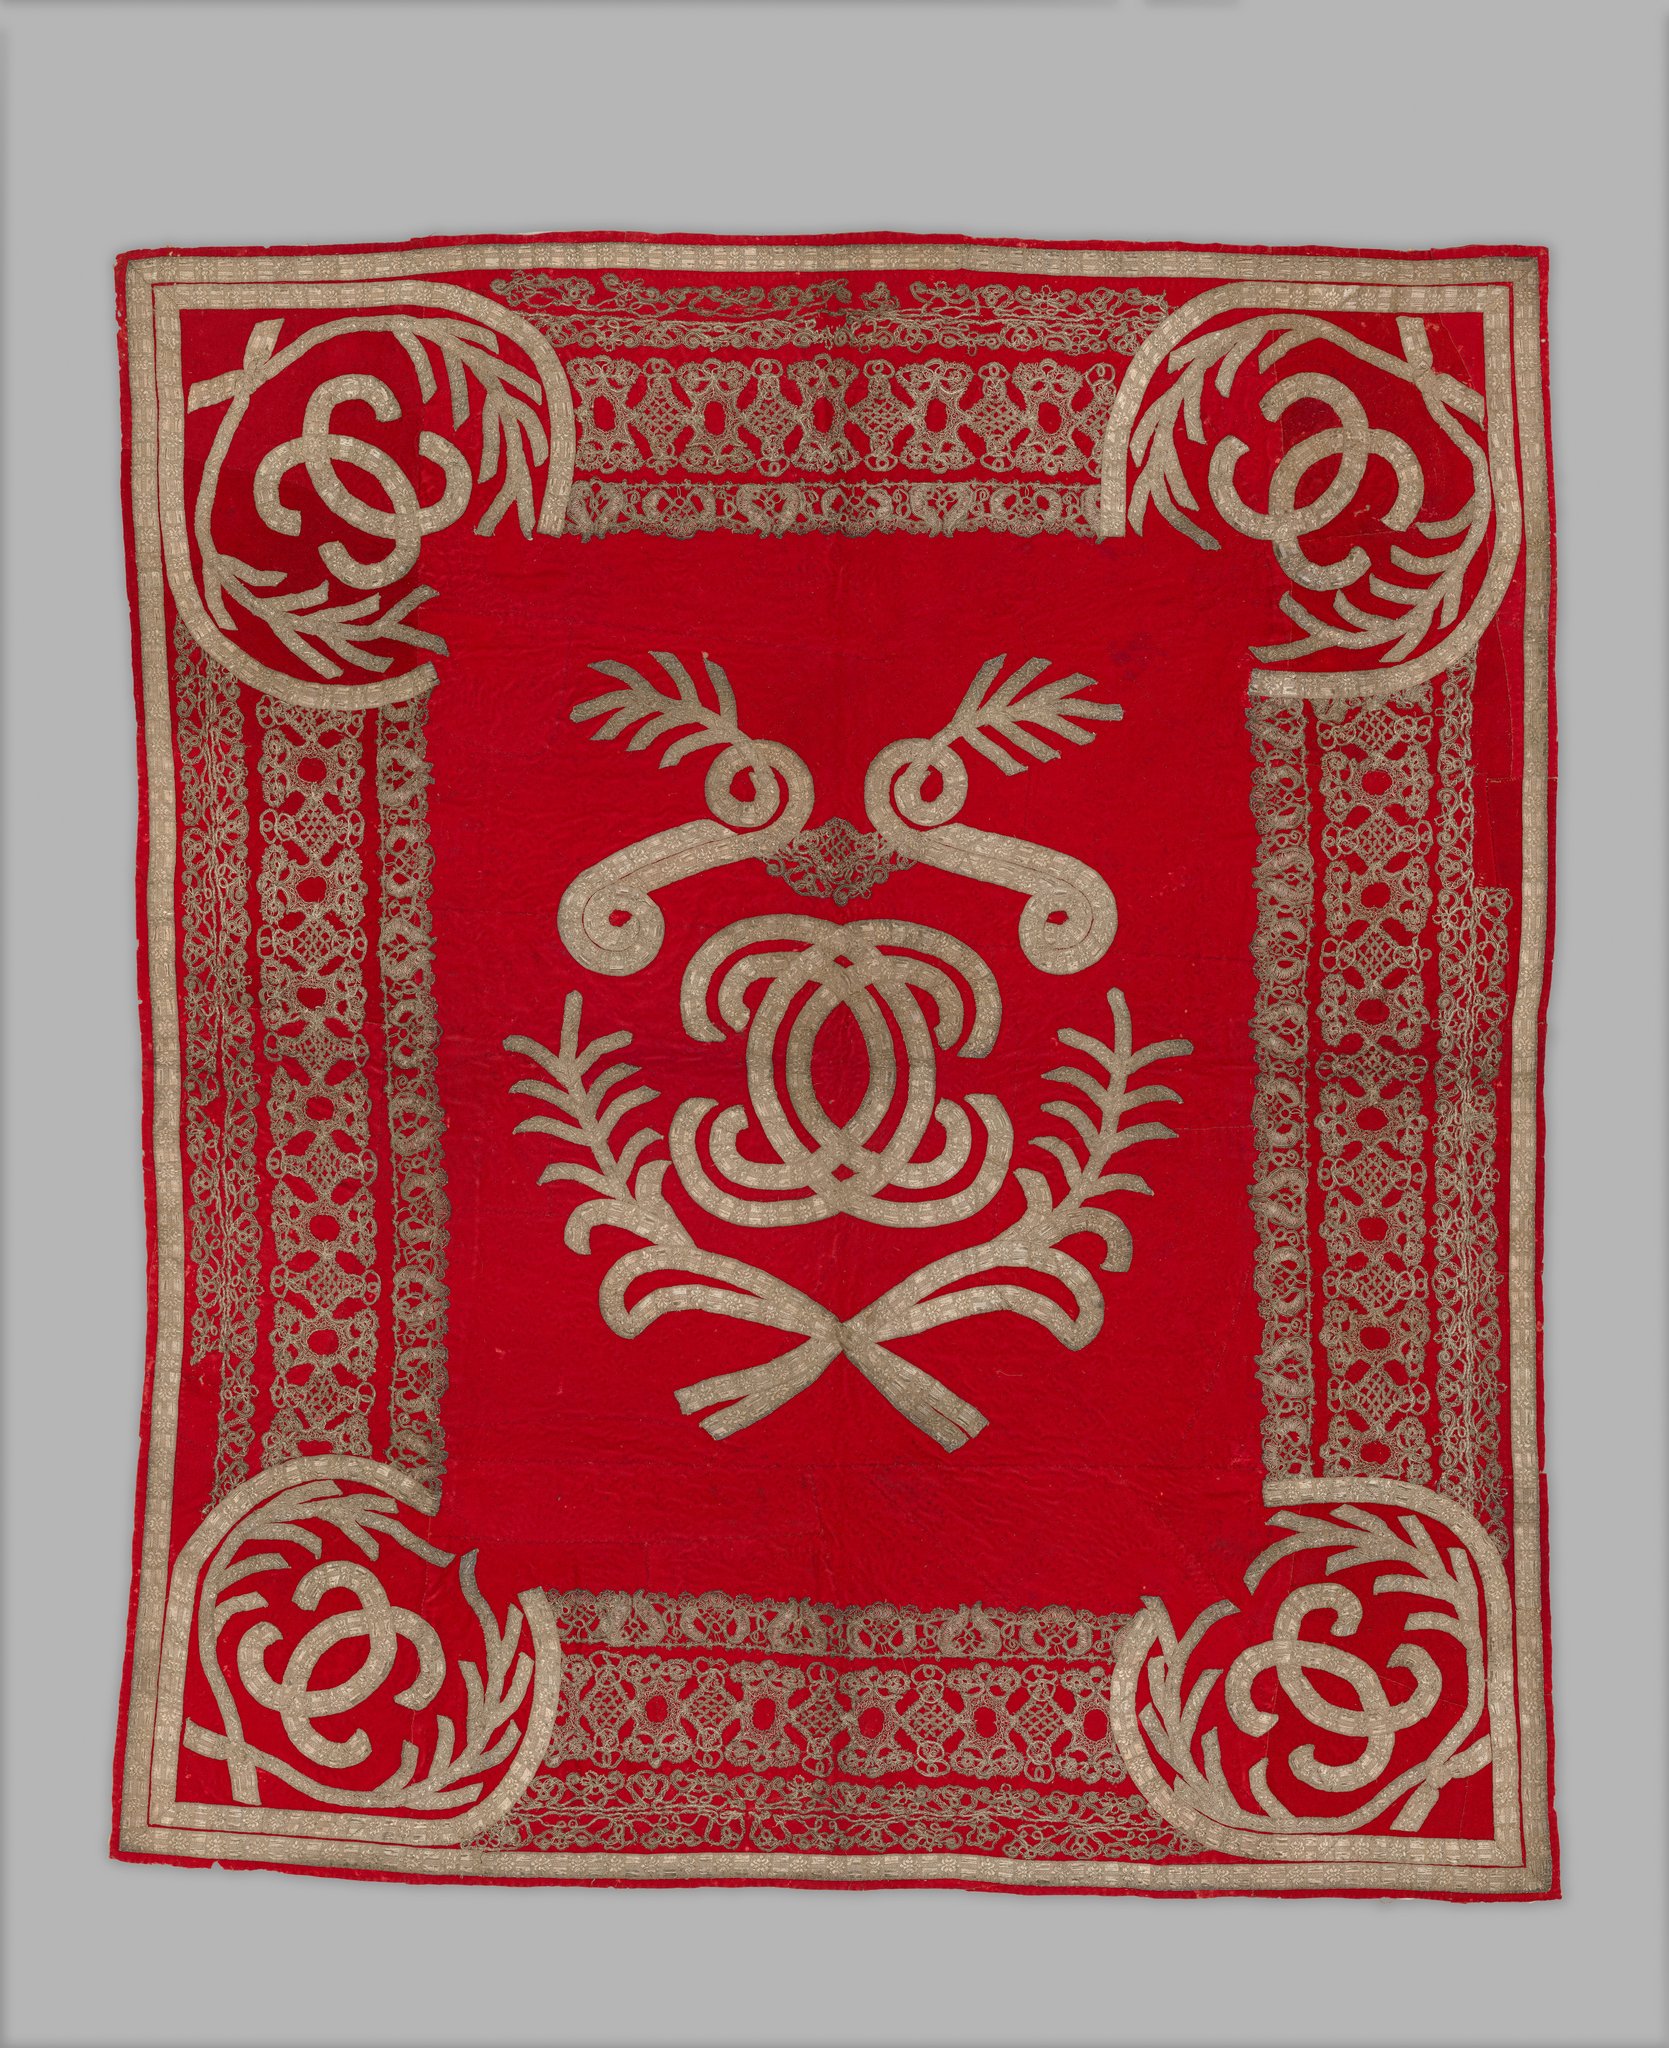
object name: carriage cloth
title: Carriage cloth, probably made for the Cavendish family, Dukes of Devonshire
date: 1701-1800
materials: metal thread, silk, wool